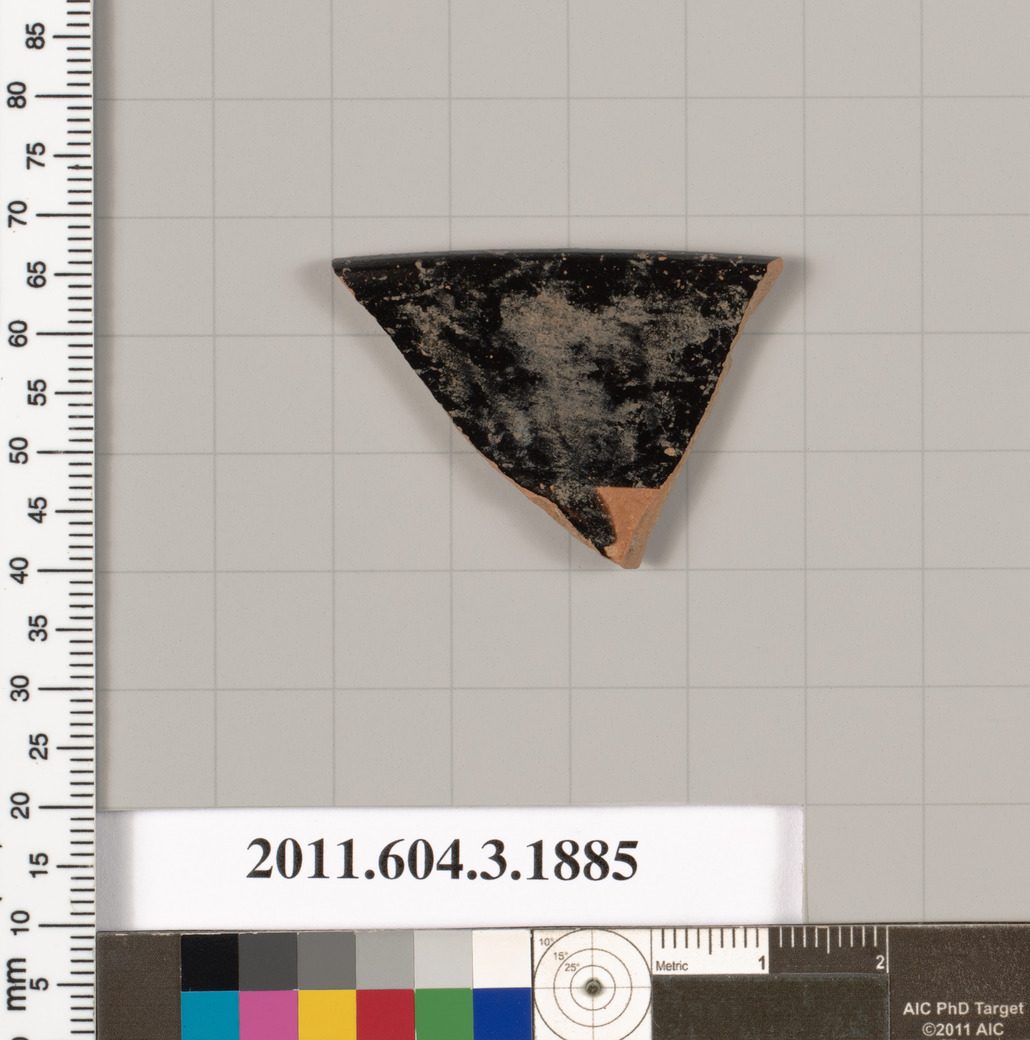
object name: terracotta rim fragment of an open shape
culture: greek, attic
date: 600-401 BCE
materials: terracotta